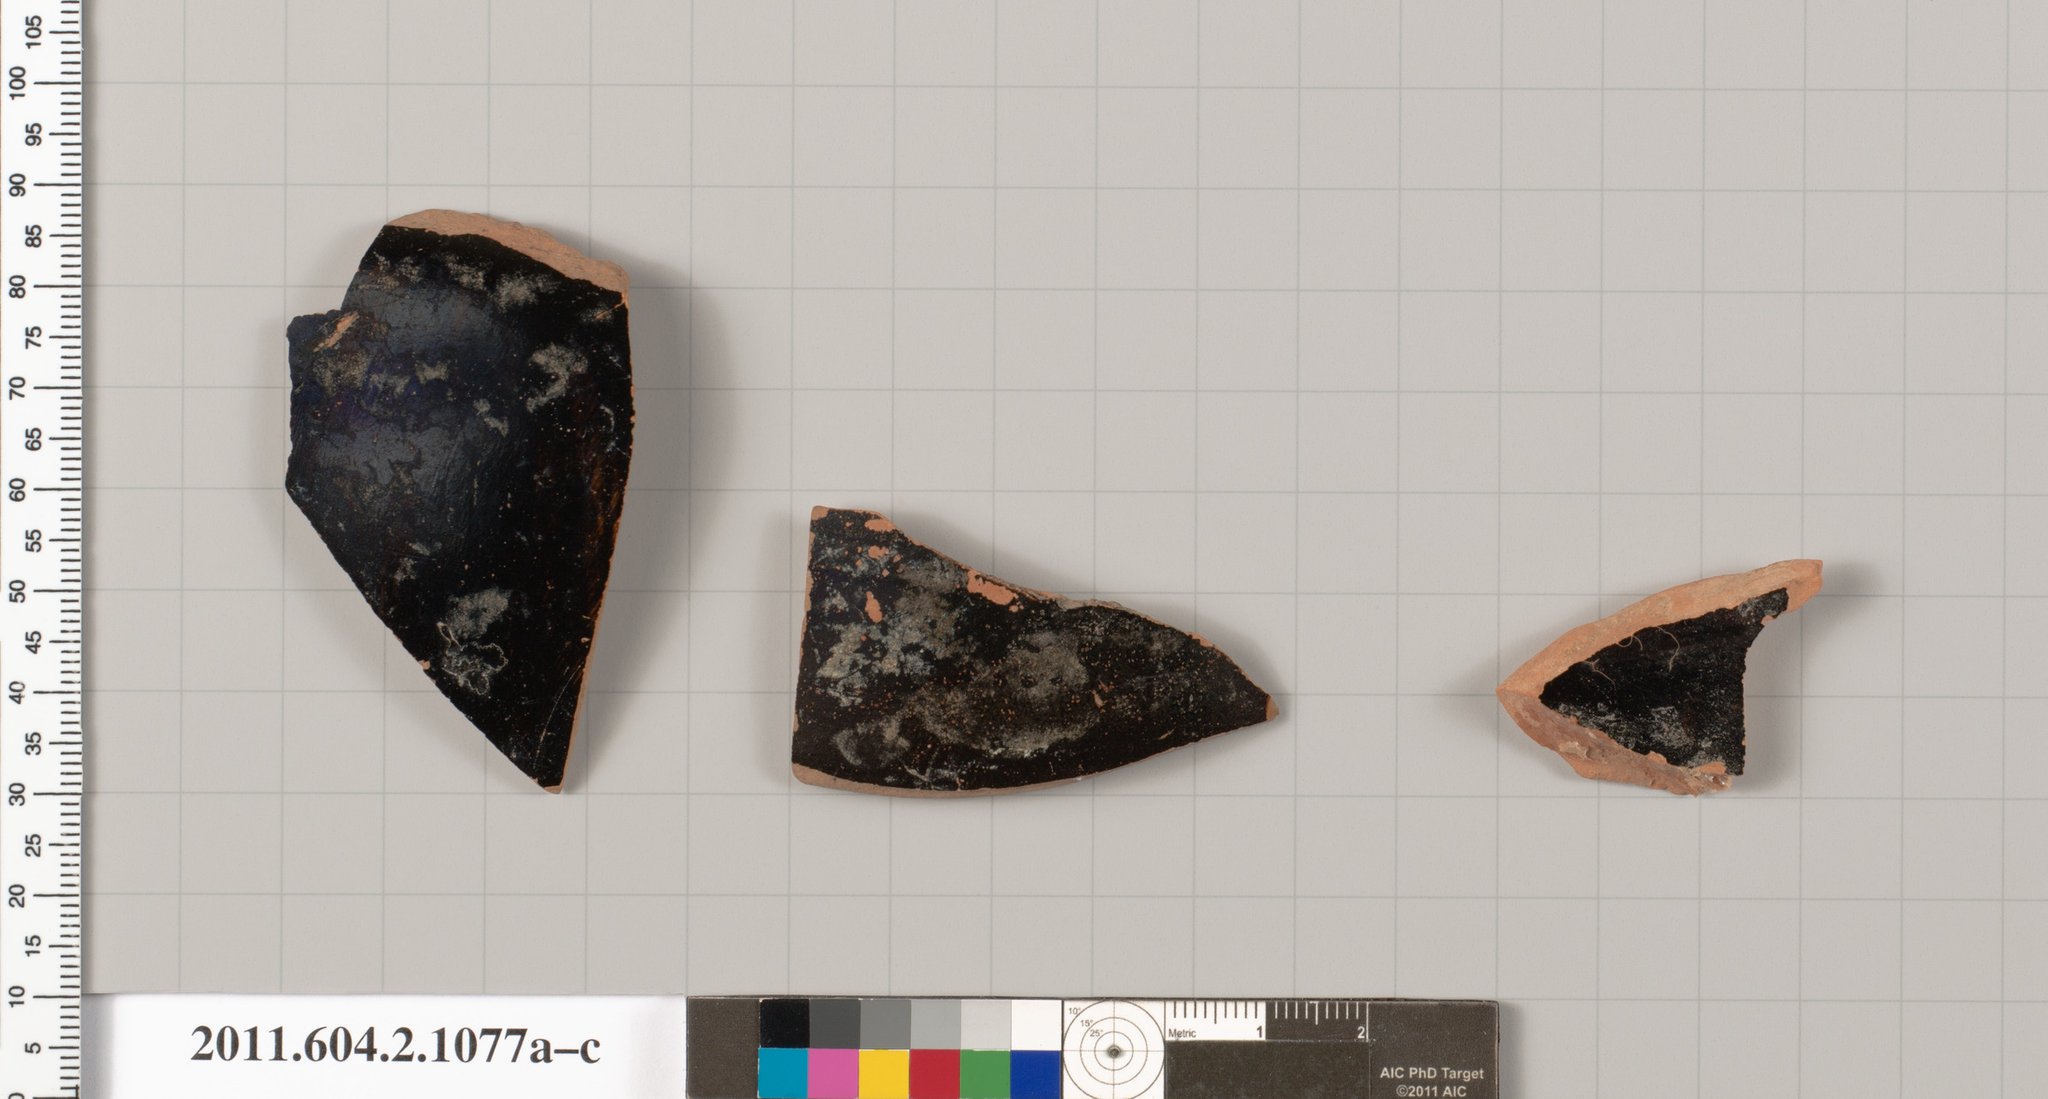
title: Terracotta fragments of closed shapes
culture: greek, attic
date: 450-401 BCE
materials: terracotta